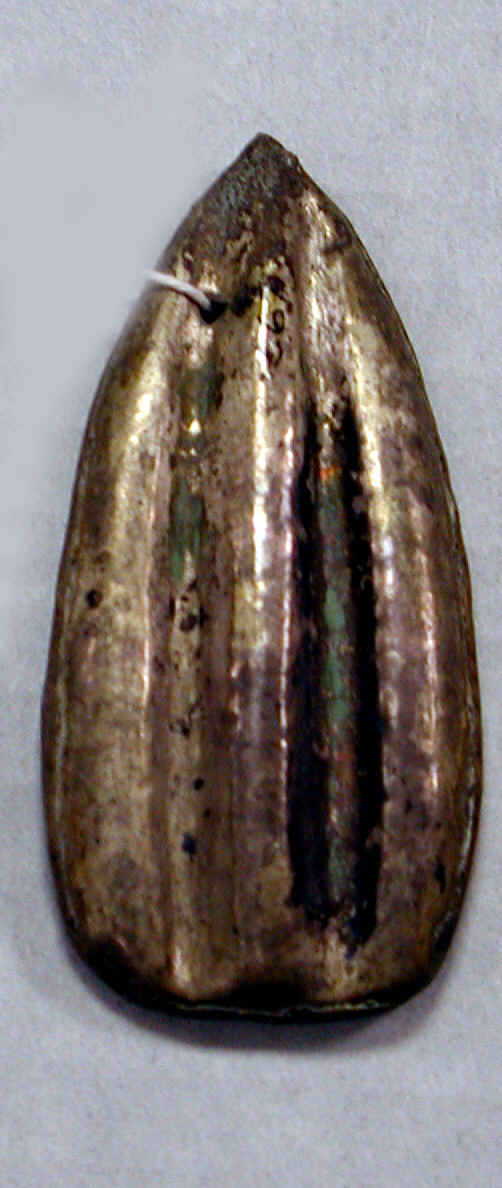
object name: ornament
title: Hammered Silver Petal Ornament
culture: peruvian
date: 701-1566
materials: gilt, silver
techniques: hammering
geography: peru